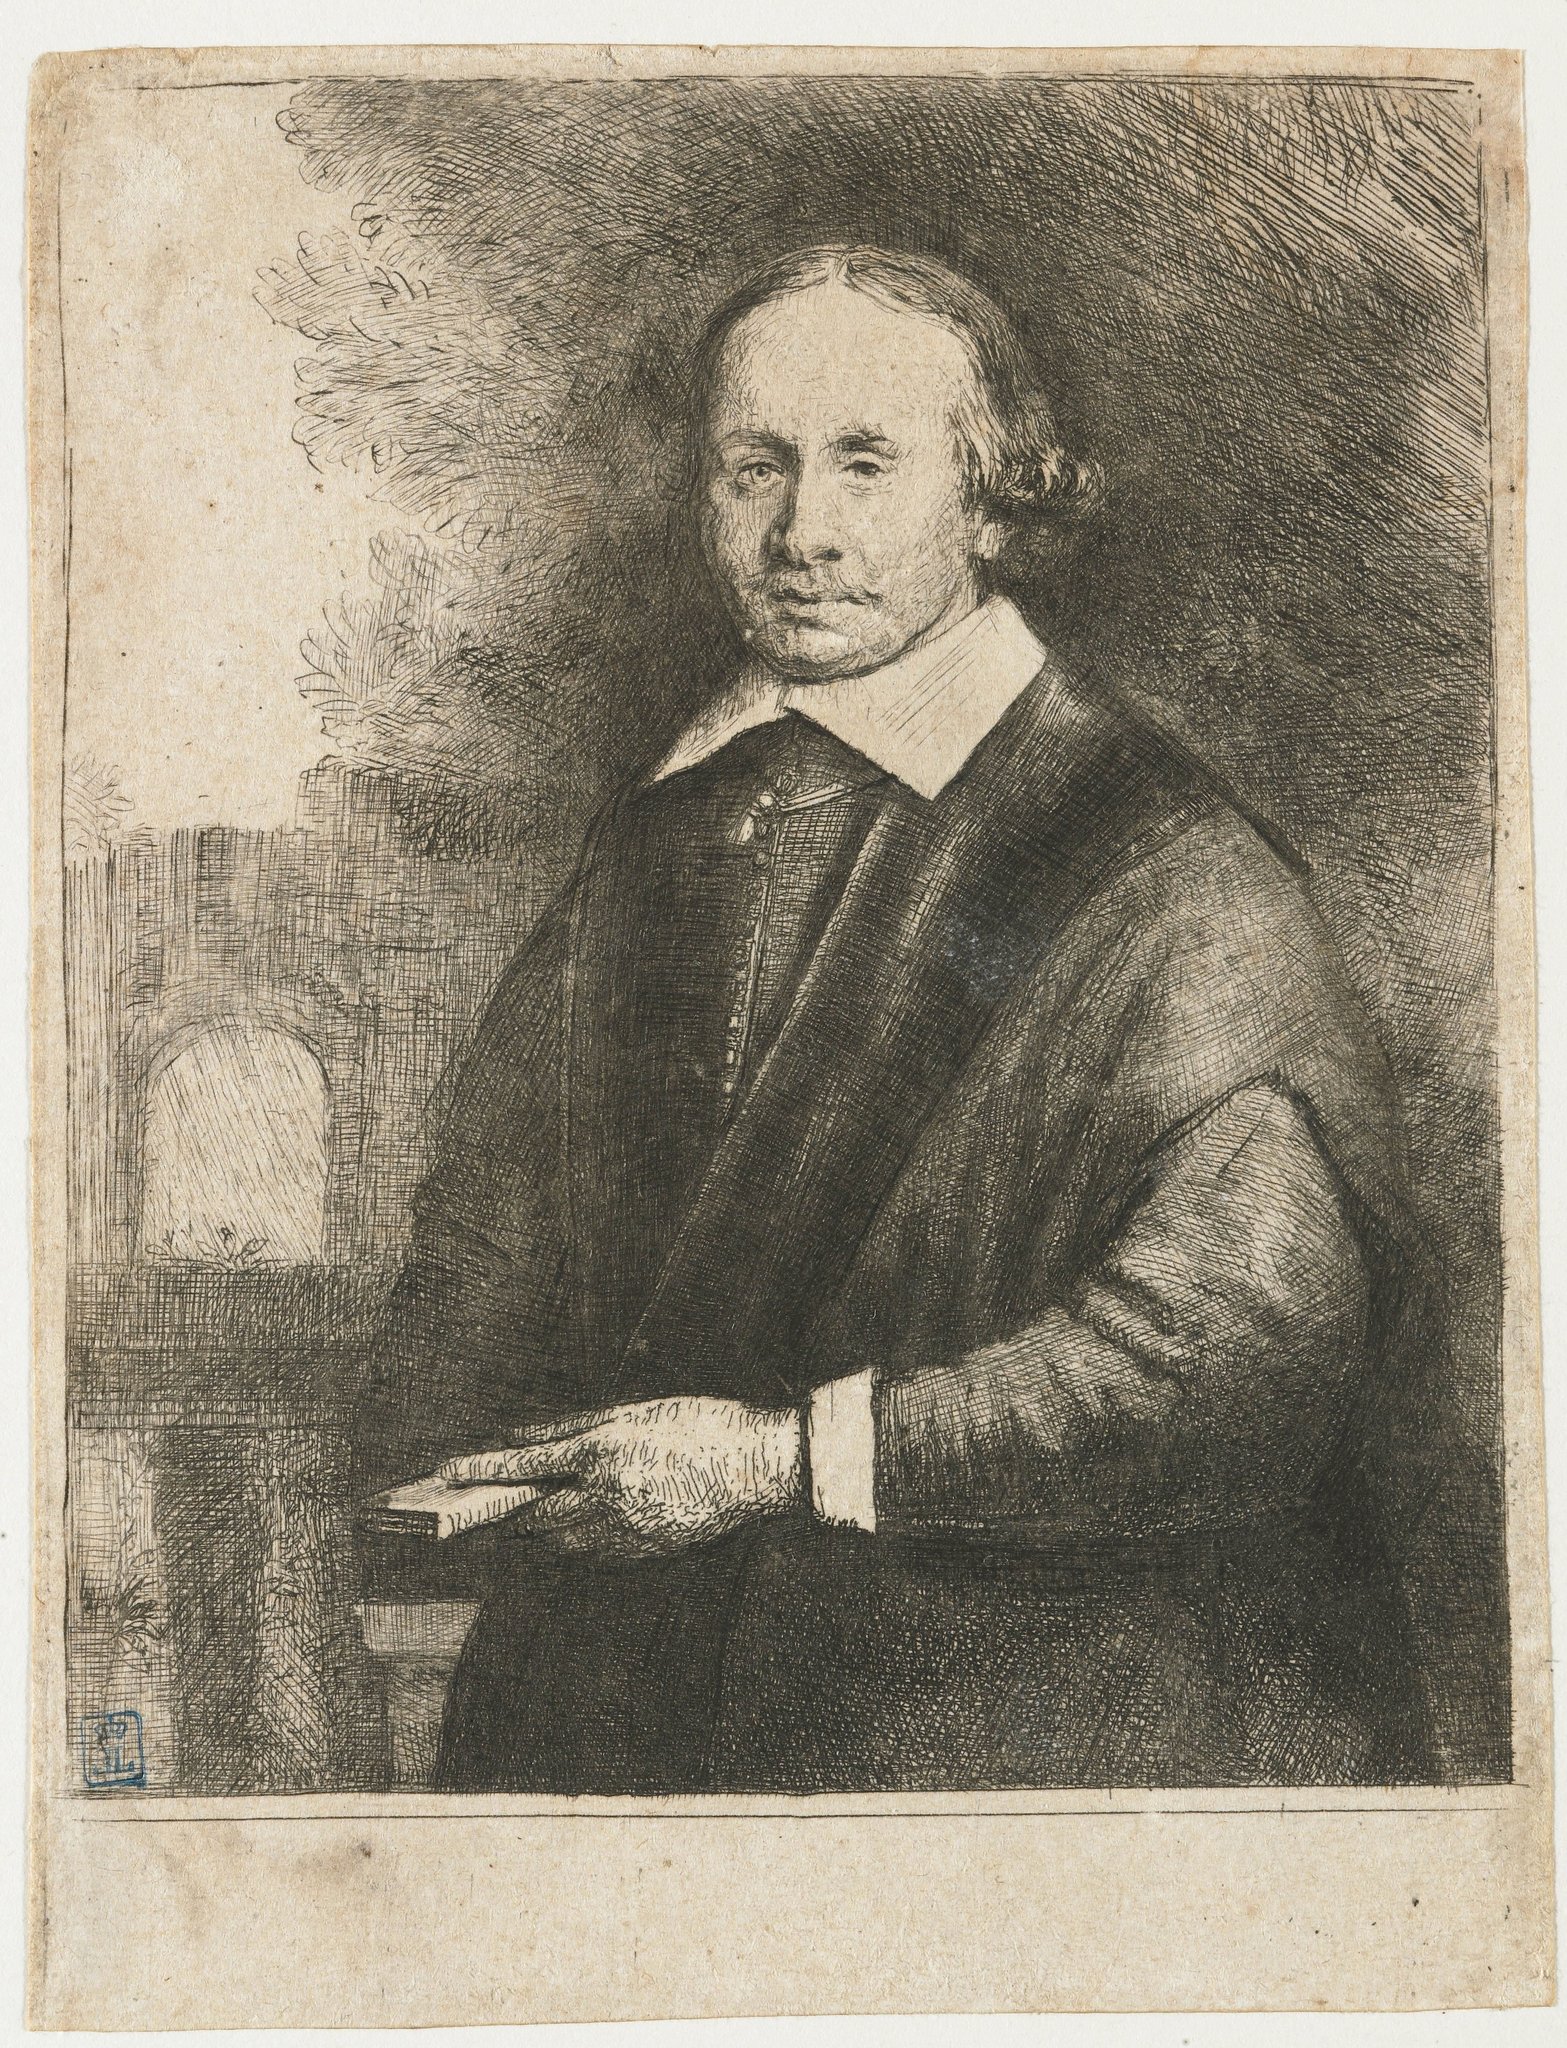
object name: print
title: Jan Antonides van der Linden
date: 1665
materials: paper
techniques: drypoint, etching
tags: enkhuizen, leiden, jan antonides van der linden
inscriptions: collector's mark: Lugt 261, collector's mark: Lugt 2228 a, collector's mark: Lugt 261, collector's mark: Lugt 1741